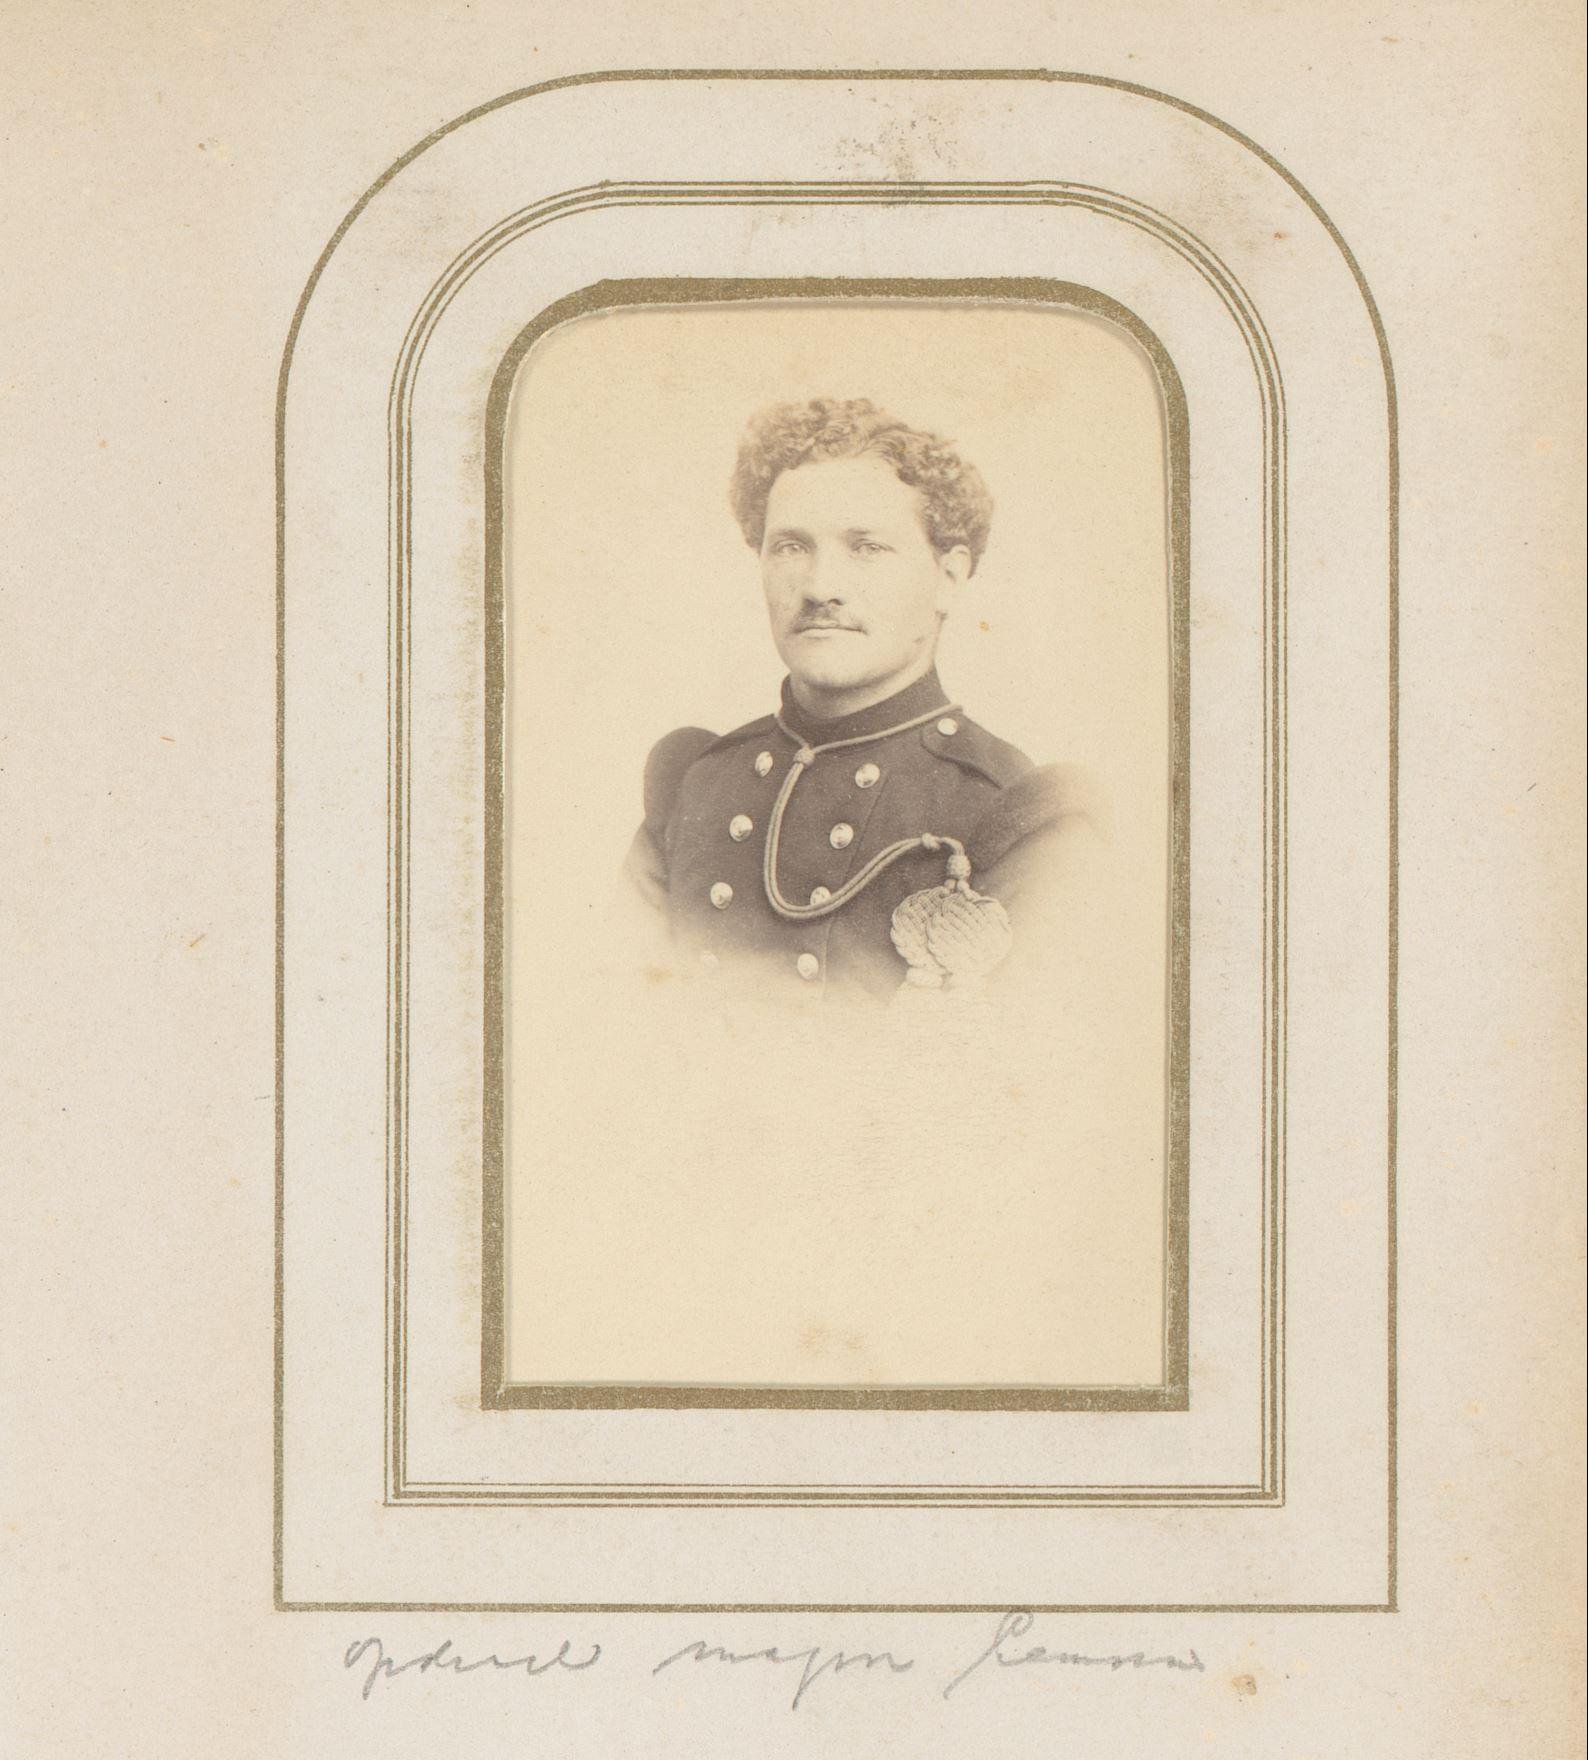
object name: album leaf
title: Portret van een man met snor in uniform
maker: albert delabarre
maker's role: musician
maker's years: 1809-1885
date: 1866-1884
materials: cardboard, photographic support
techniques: albumen print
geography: brussels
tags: moustache, historical persons, (military) uniforms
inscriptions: annotation: ‘Souvenir d'amitié et de reconnaissance/ à mon brave major Lemoine/ [...]’, annotation: ‘opdracht major Lemoine’, inscription: ‘Photograhie Parisienne/ 36, Rue Fossé aux Loups, 36/ (Place de la Monnaie)/ Bruxelles’